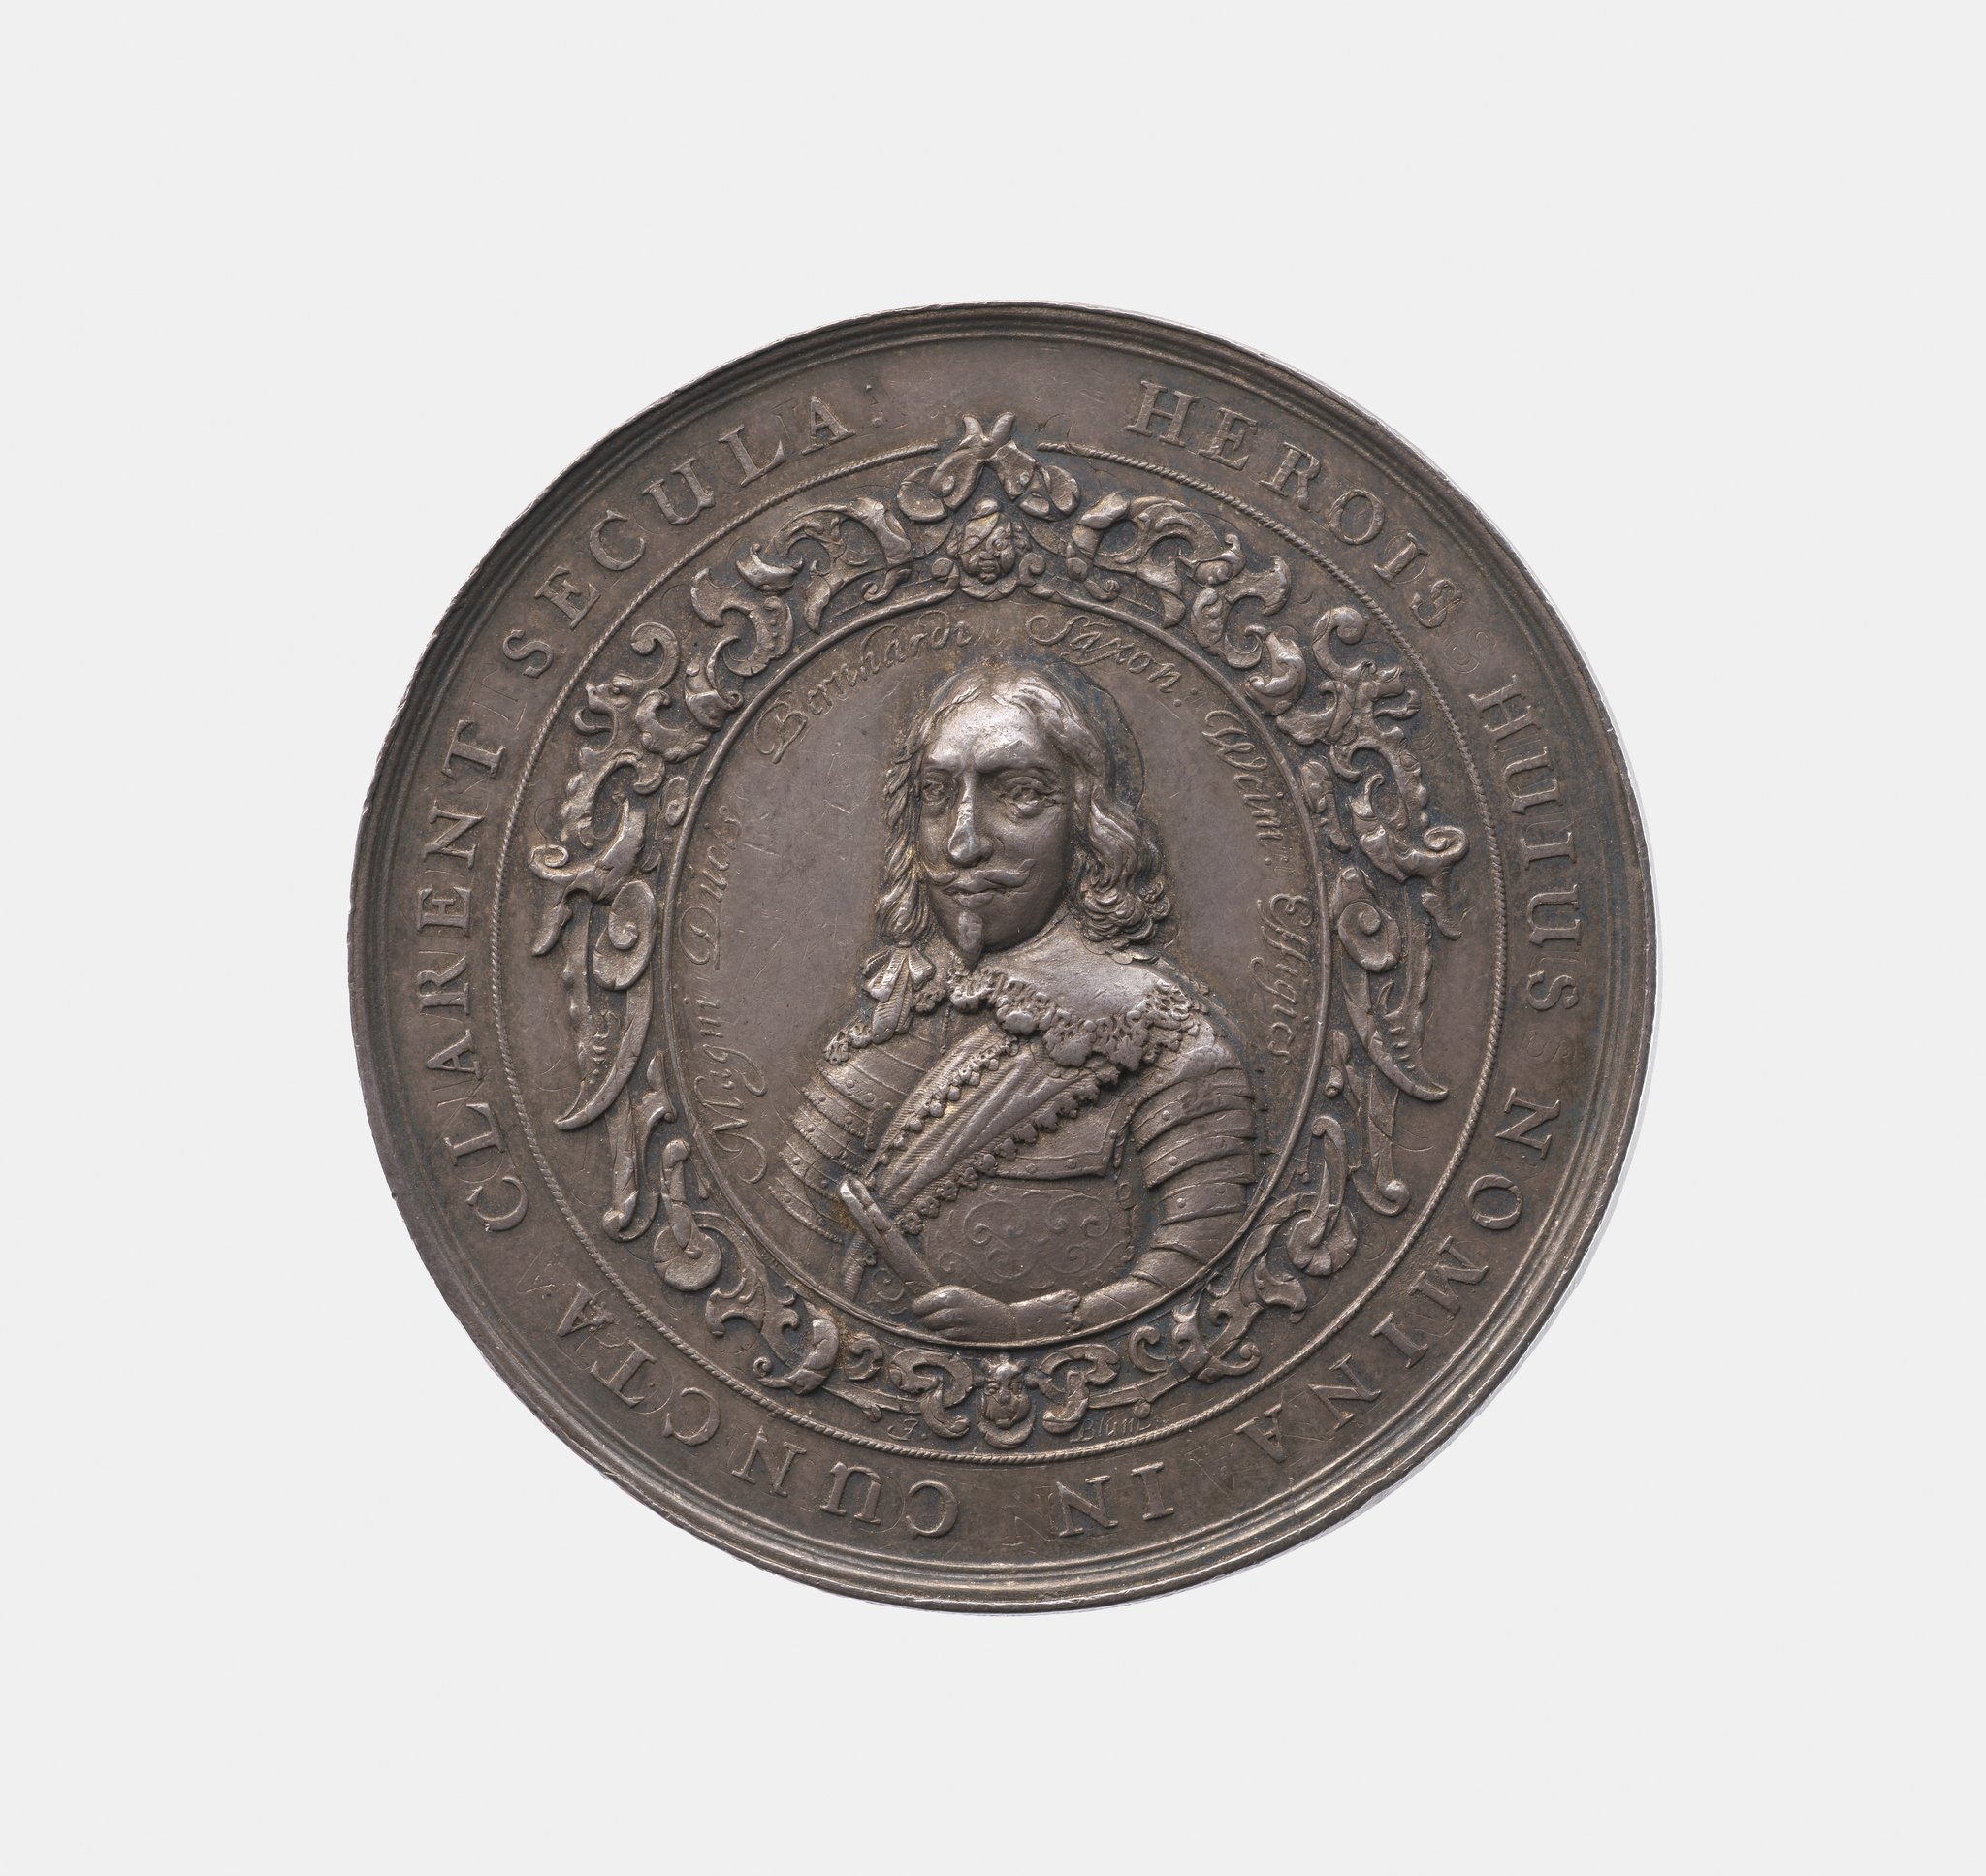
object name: medal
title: Bernhard of Saxe-Weimar 1604-39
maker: johann blum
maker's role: artist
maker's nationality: german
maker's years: 1599-1689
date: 1638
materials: silver